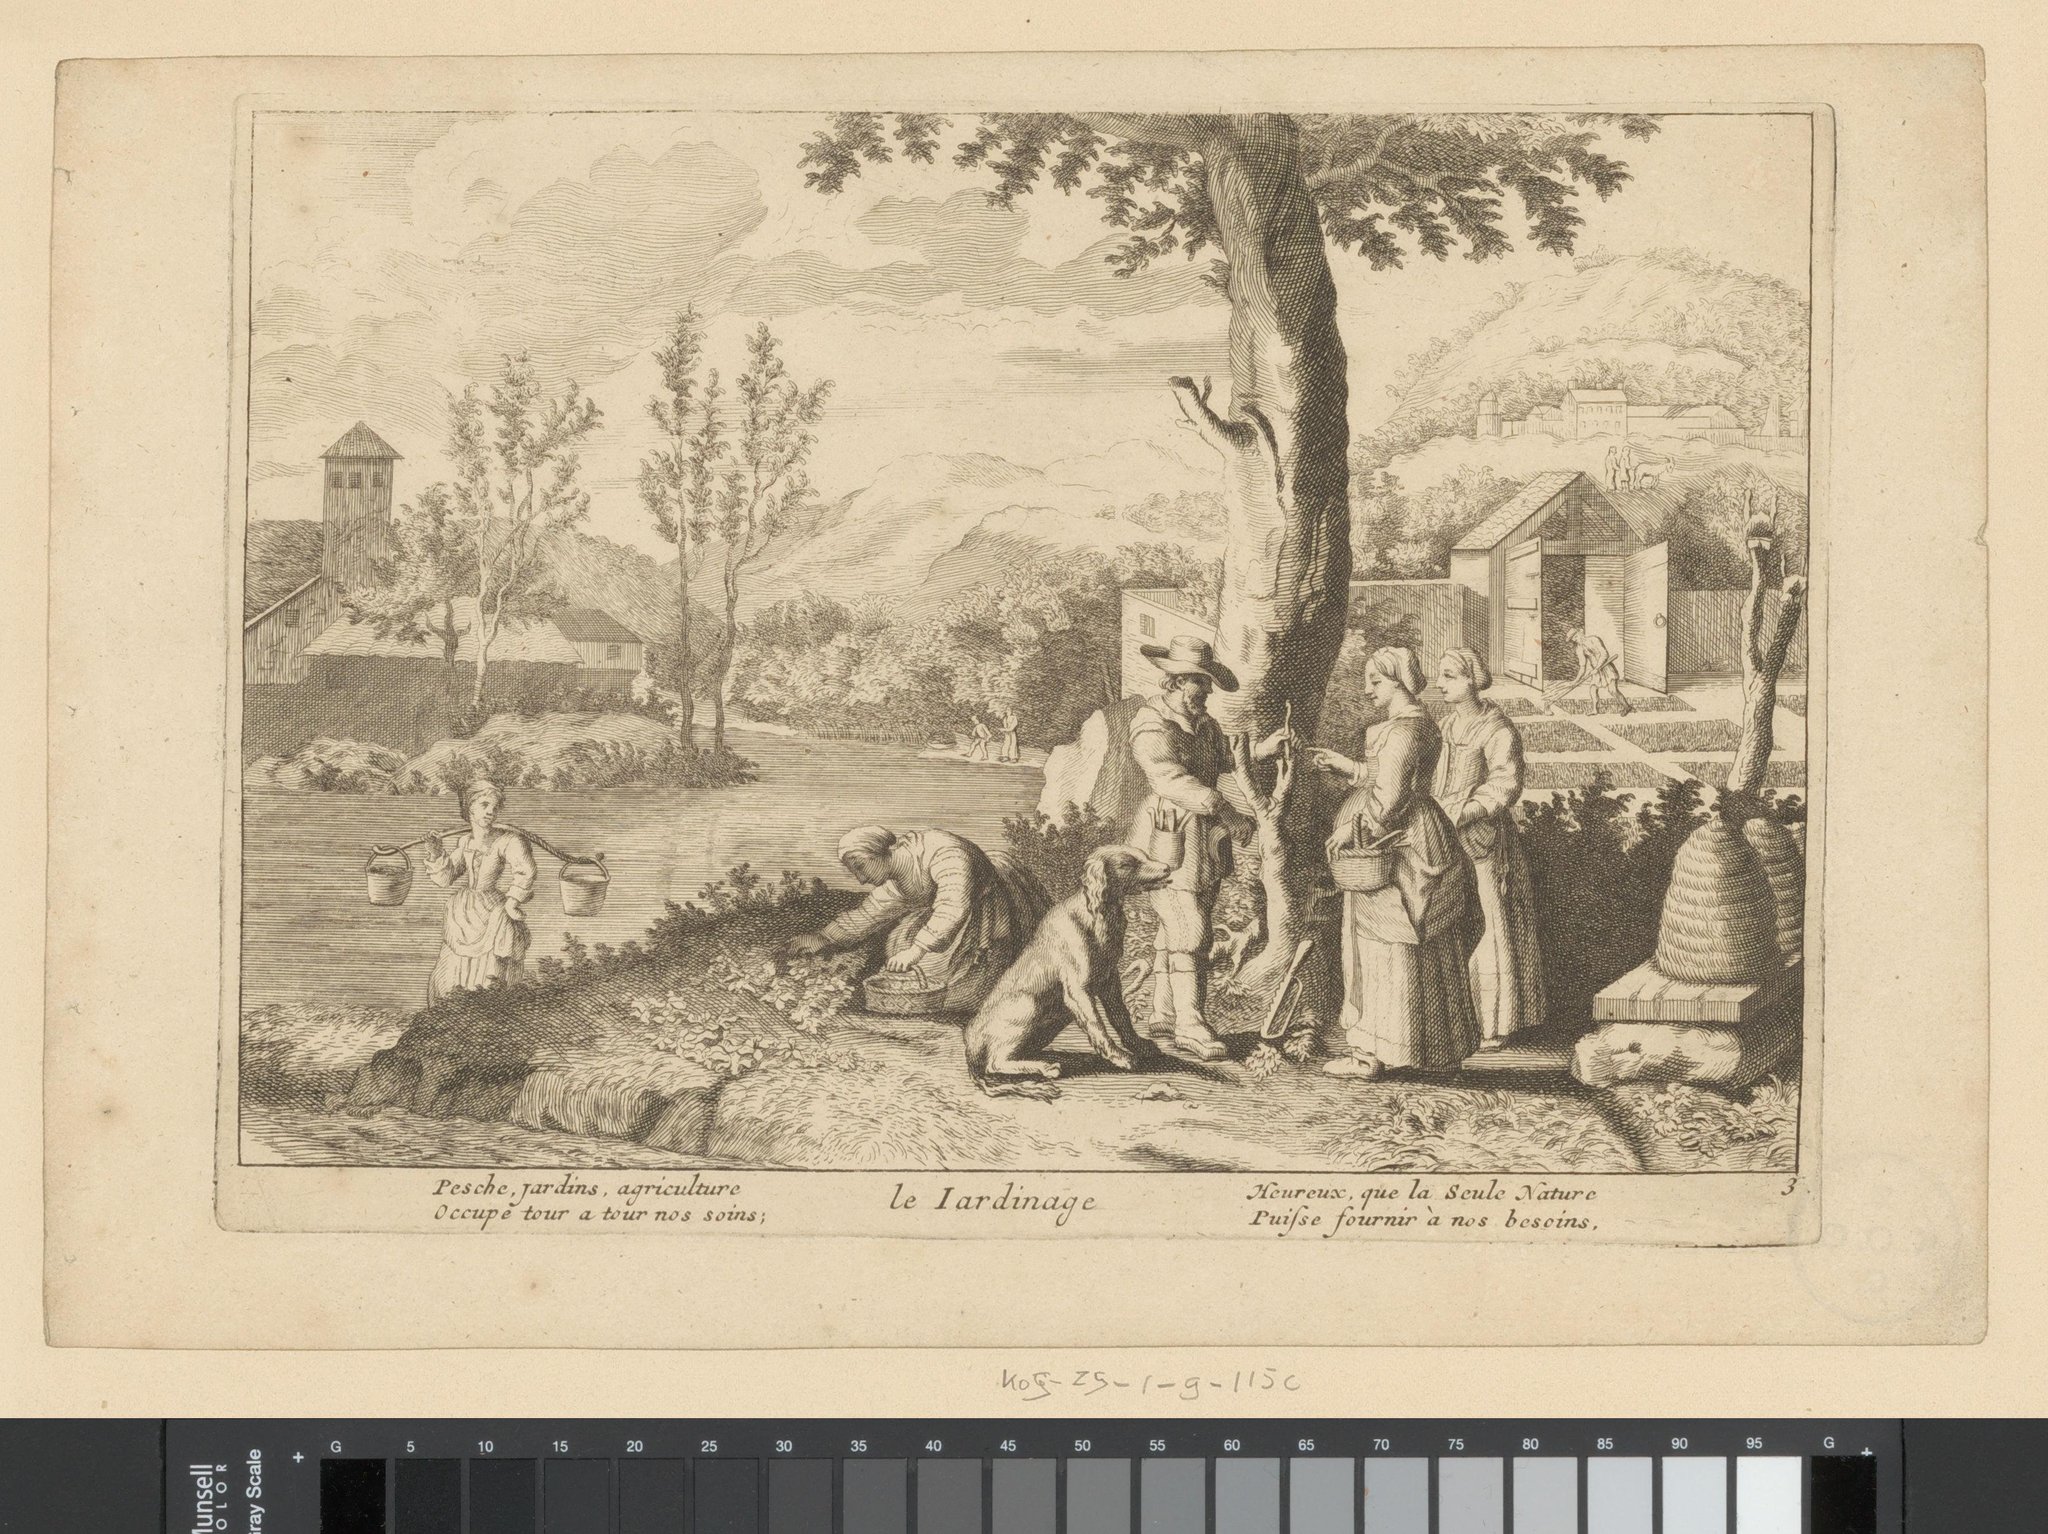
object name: print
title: Tuinierende figuren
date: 1670-1726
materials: paper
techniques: engraving, etching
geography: amsterdam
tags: bee-hive, gardening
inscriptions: collector's mark: Lugt 1641, stamp:, collector's mark: Lugt 1641, stamp:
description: Genummerd rechtsonder: 3. Onderwerpsrubrieken binnen de Atlas Zeden en Gewoonten: Handel, nijverheid en verkeer, Boerenleven.